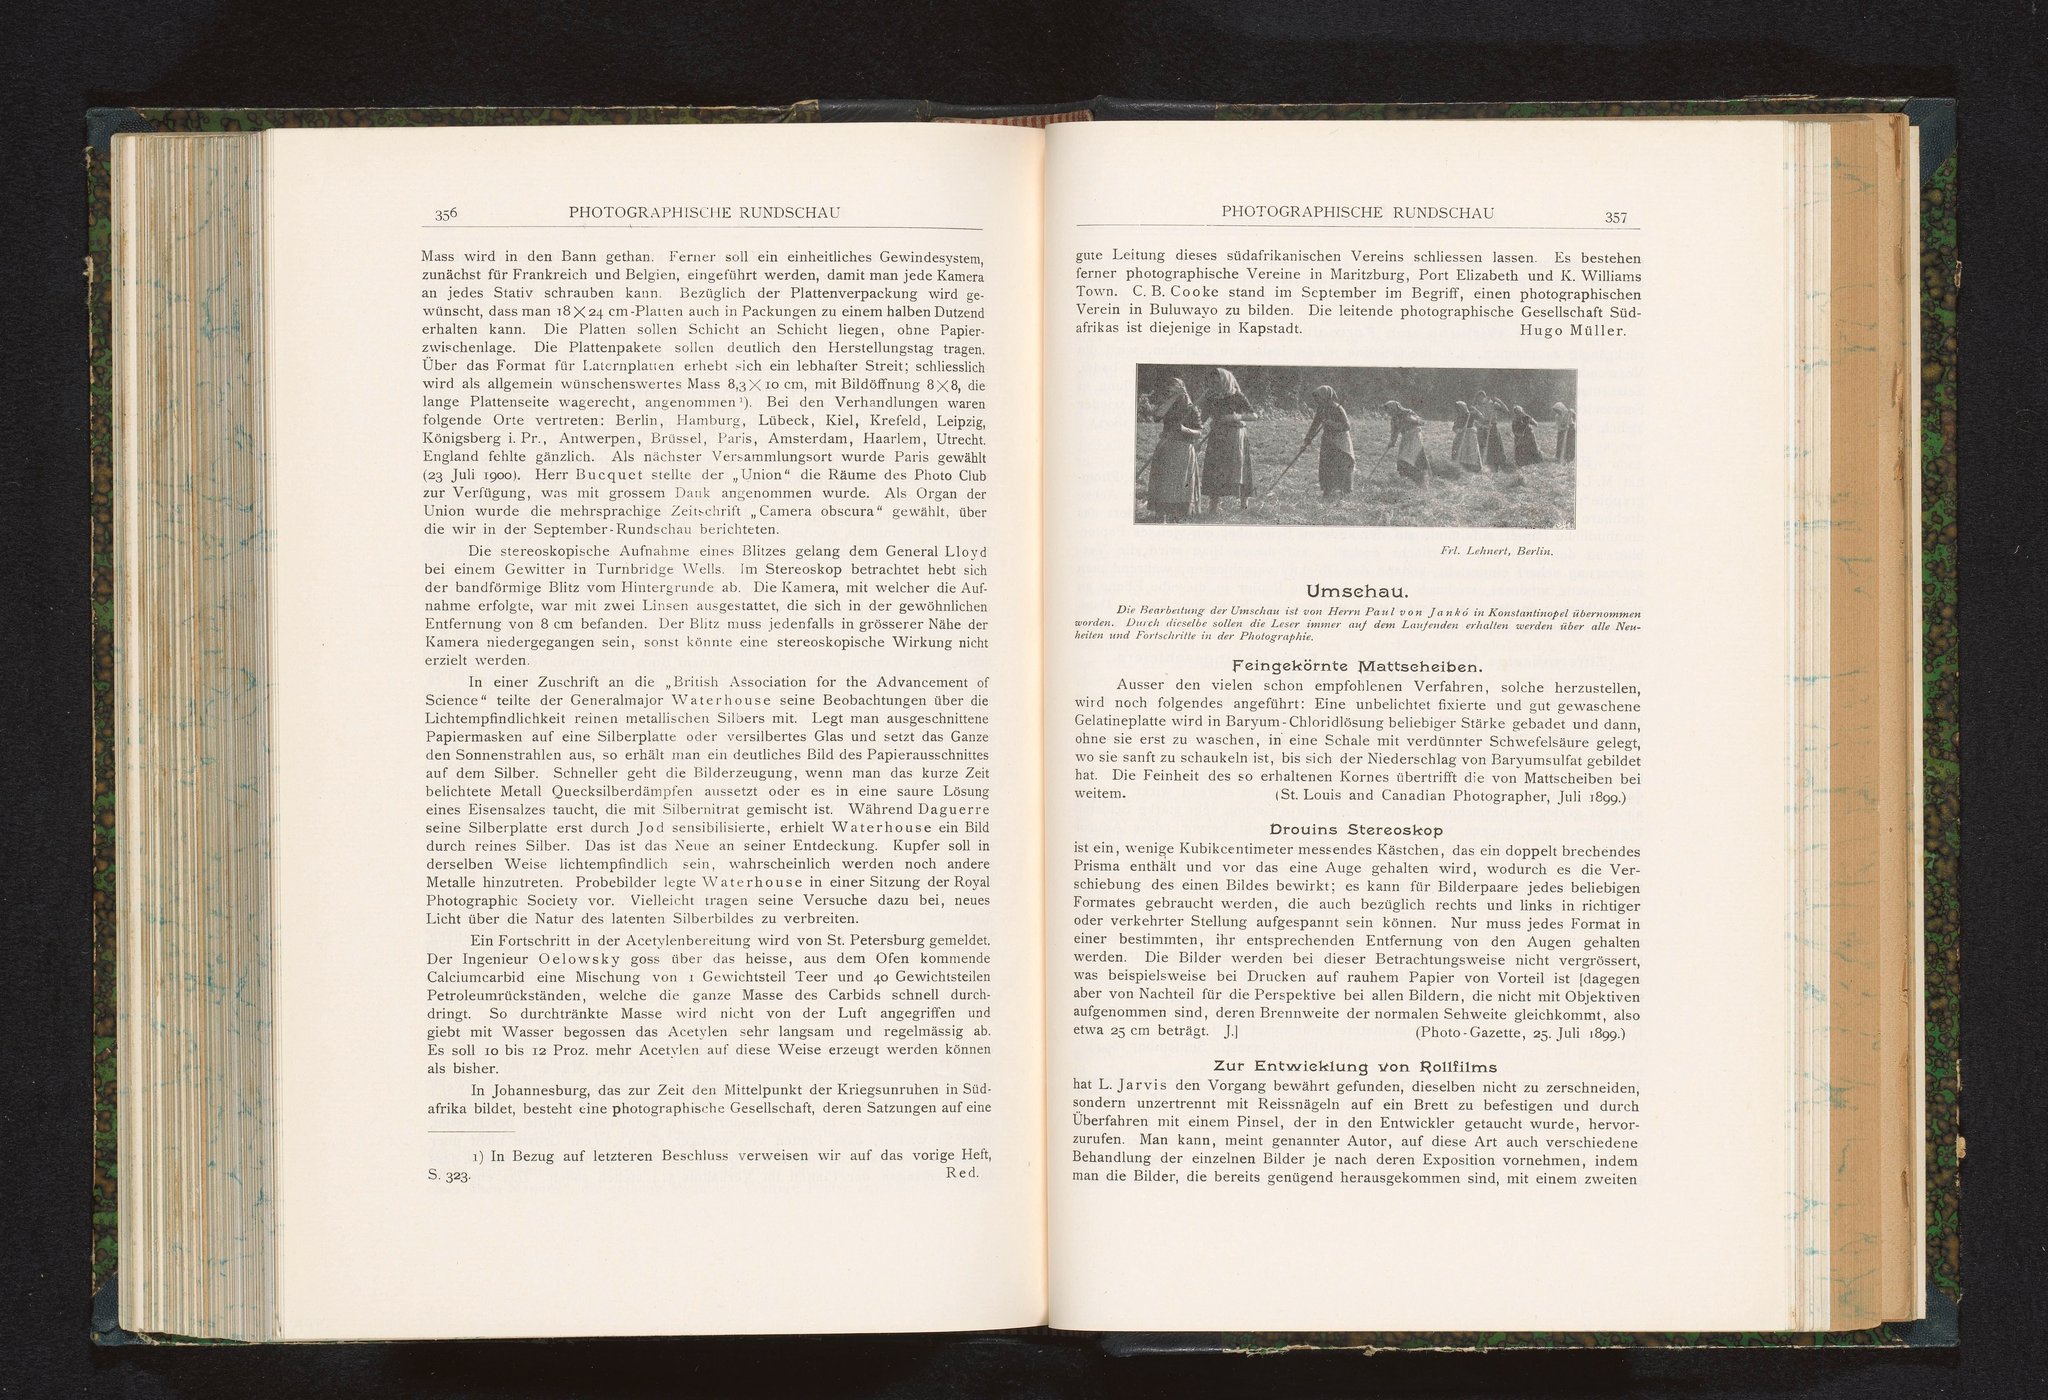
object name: page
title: Groep vrouwen aan het werk op het land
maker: hildegard lehnert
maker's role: painter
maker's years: 1857-1943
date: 1894-1899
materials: paper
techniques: autotype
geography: berlin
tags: cultivation ~ agriculture (+ women (labourers))